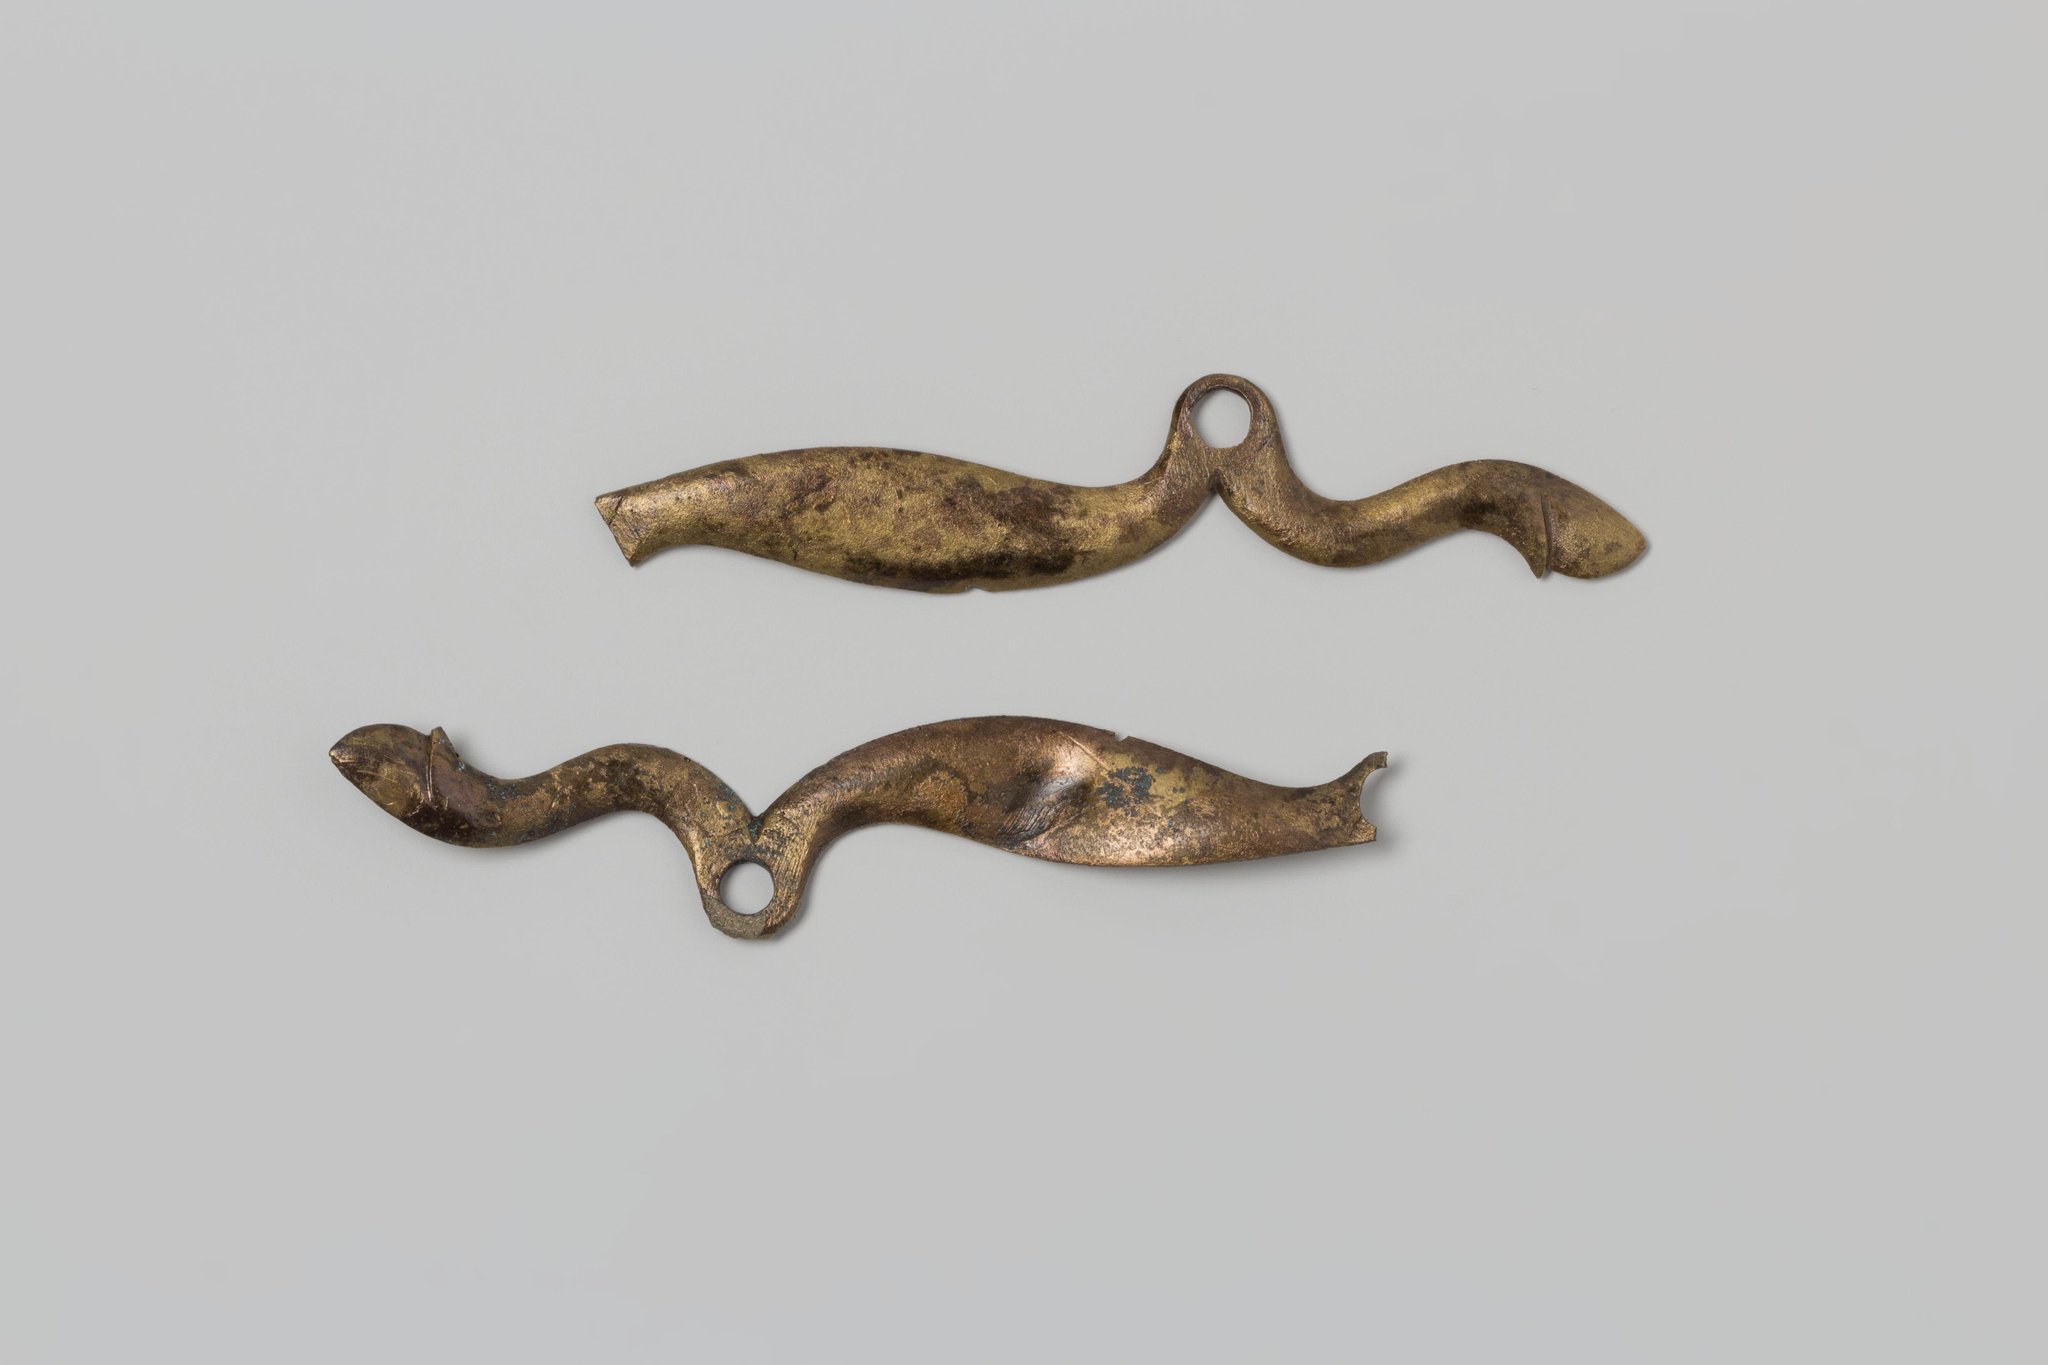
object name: pistol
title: Fragment zijplaat van een pistool uit het wrak van de Oost-Indiëvaarder Hollandia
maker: Anonymous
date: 1700-1743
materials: copper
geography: netherlands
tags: verenigde oostindische compagnie, hollandia (schip), annet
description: Pistol, side plate; central eye with 2 curved wings, one end with a circular eye, plain slightly convex surface.